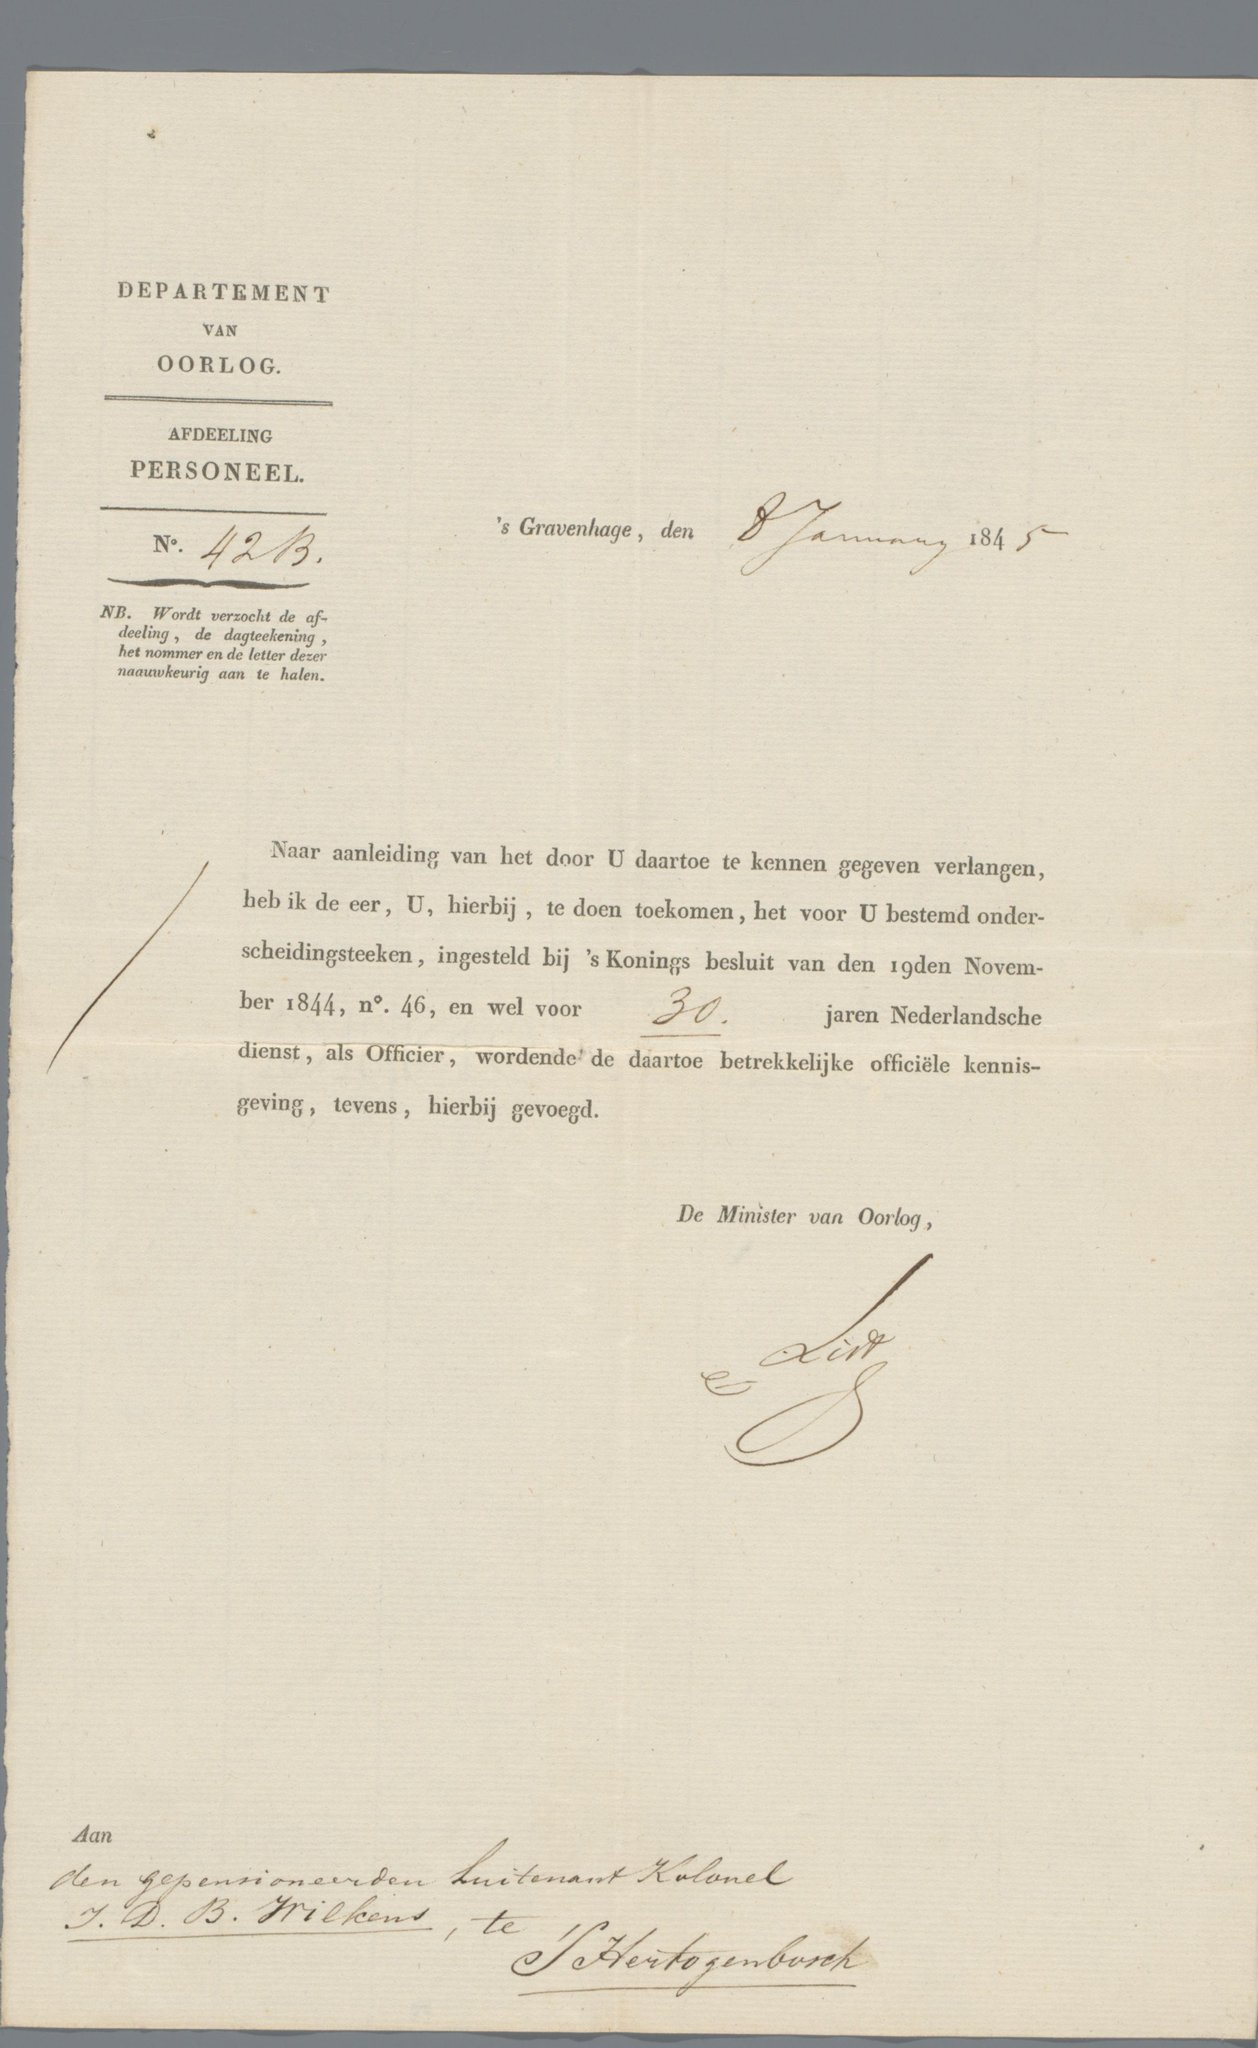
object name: letter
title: Toekenning aan de gepensioneerde J.D.B. Wilkens van het onderscheidingsteken voor 30 jaren Nederlandse dienst als officier, 8 januari 1845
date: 1845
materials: ink, paper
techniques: handwriting, pen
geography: the hague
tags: after the completion of service, netherlands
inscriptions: number: ‘11198’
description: Onderdeel van een groep van documenten betreffende de staat van dienst, benoemingen, enz. van Luitenant Kolonel van de Infanterie J.D.B. Wilkens. Behorende bij de schenking van het geschilderde portret.